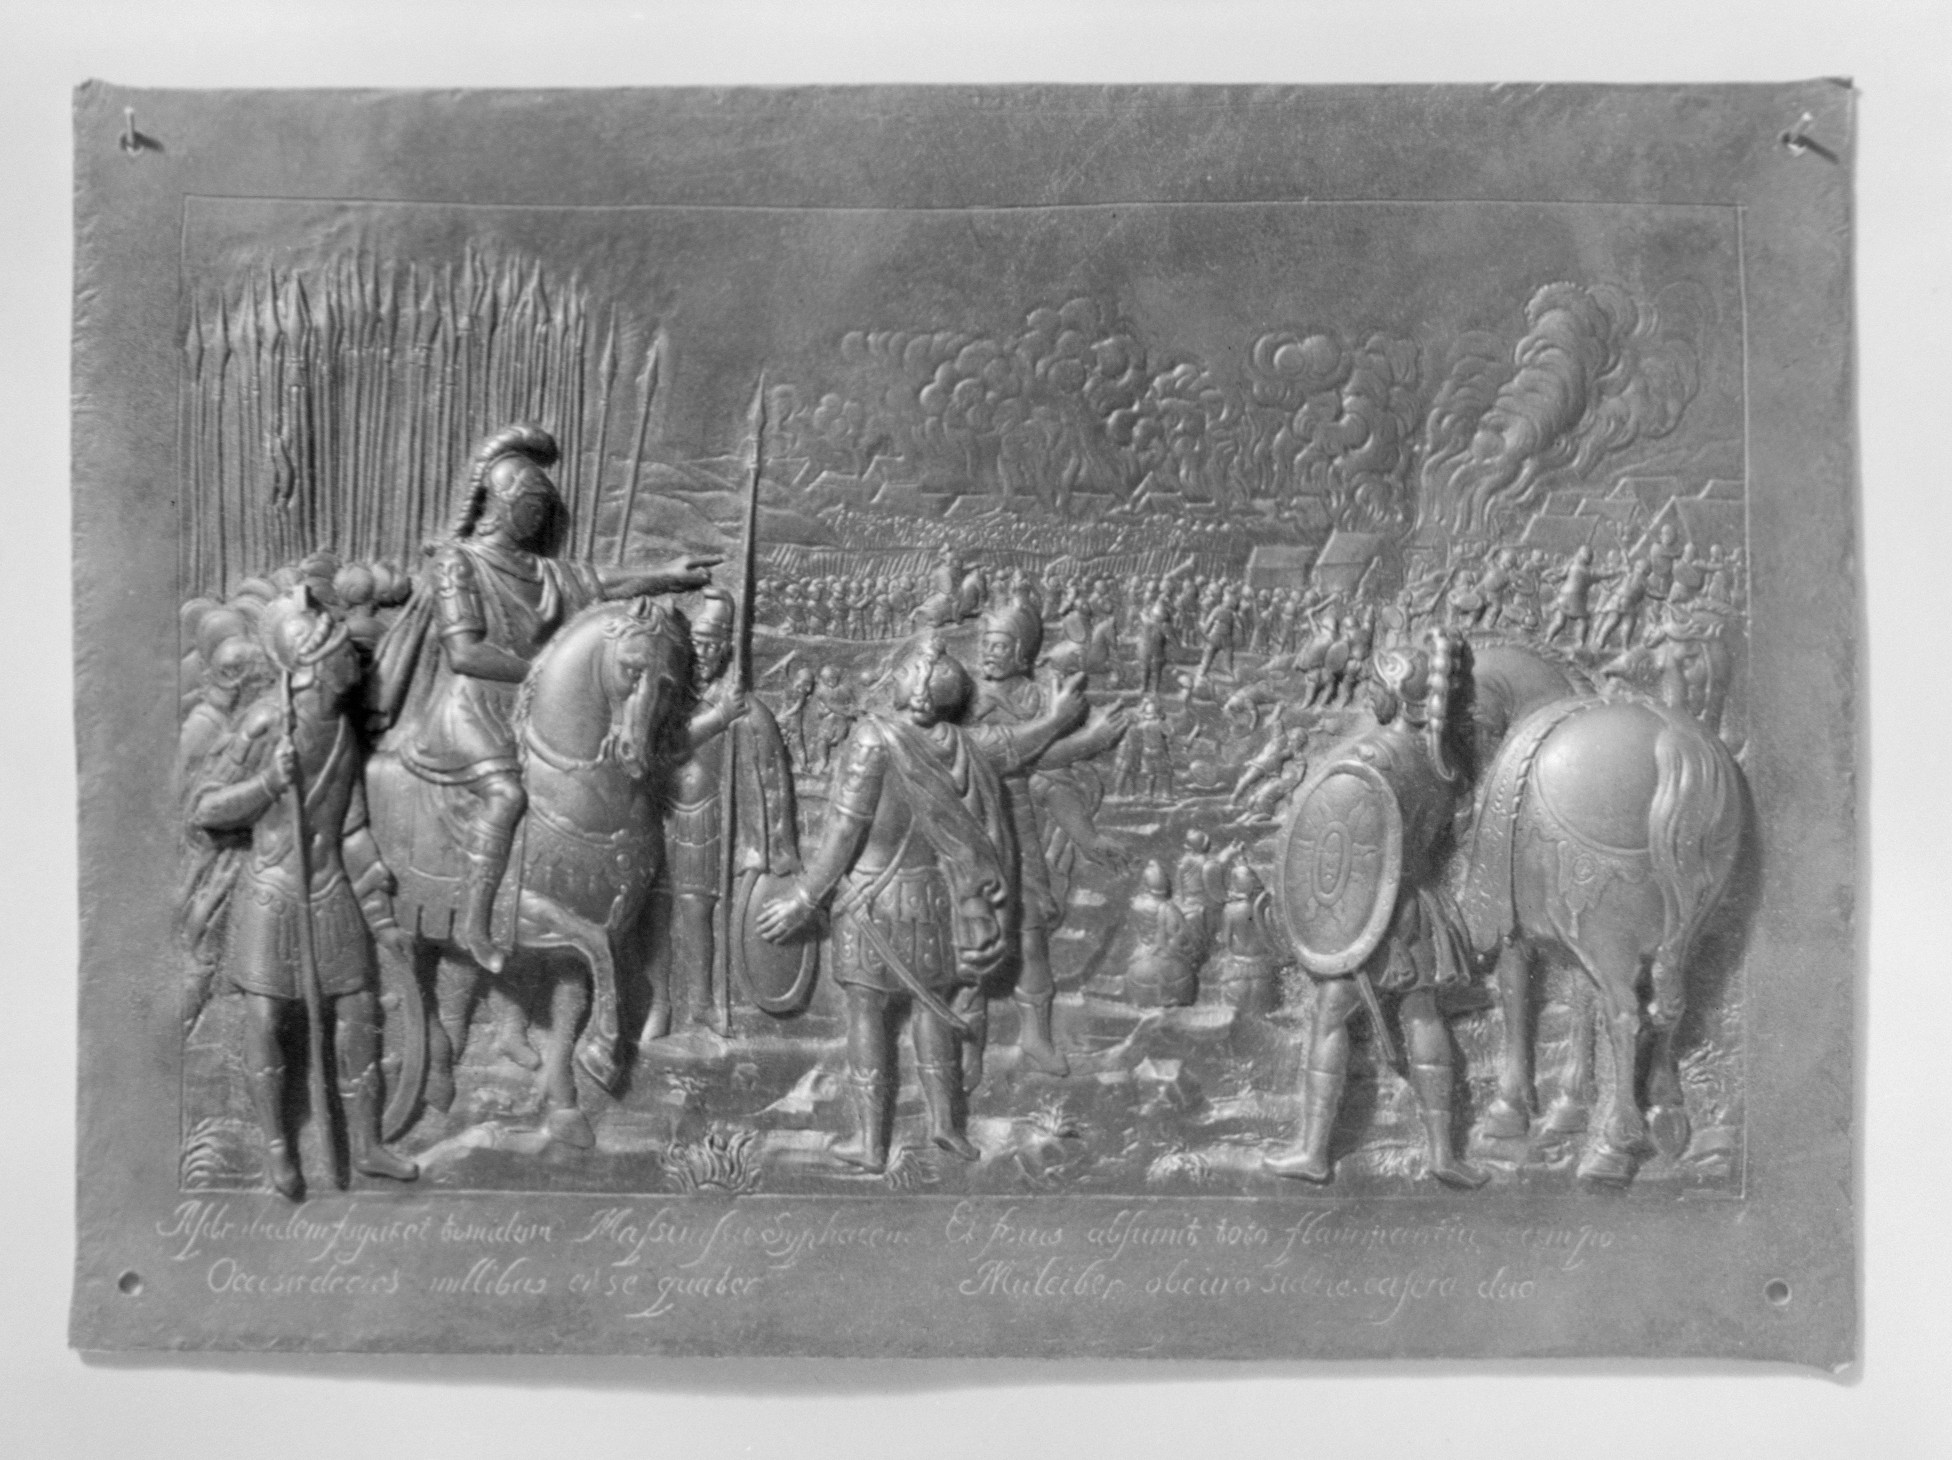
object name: relief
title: Scenes of burning camps of Syphax and Hasdrubal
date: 1601-1700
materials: iron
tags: soldiers,shields,spears,horses